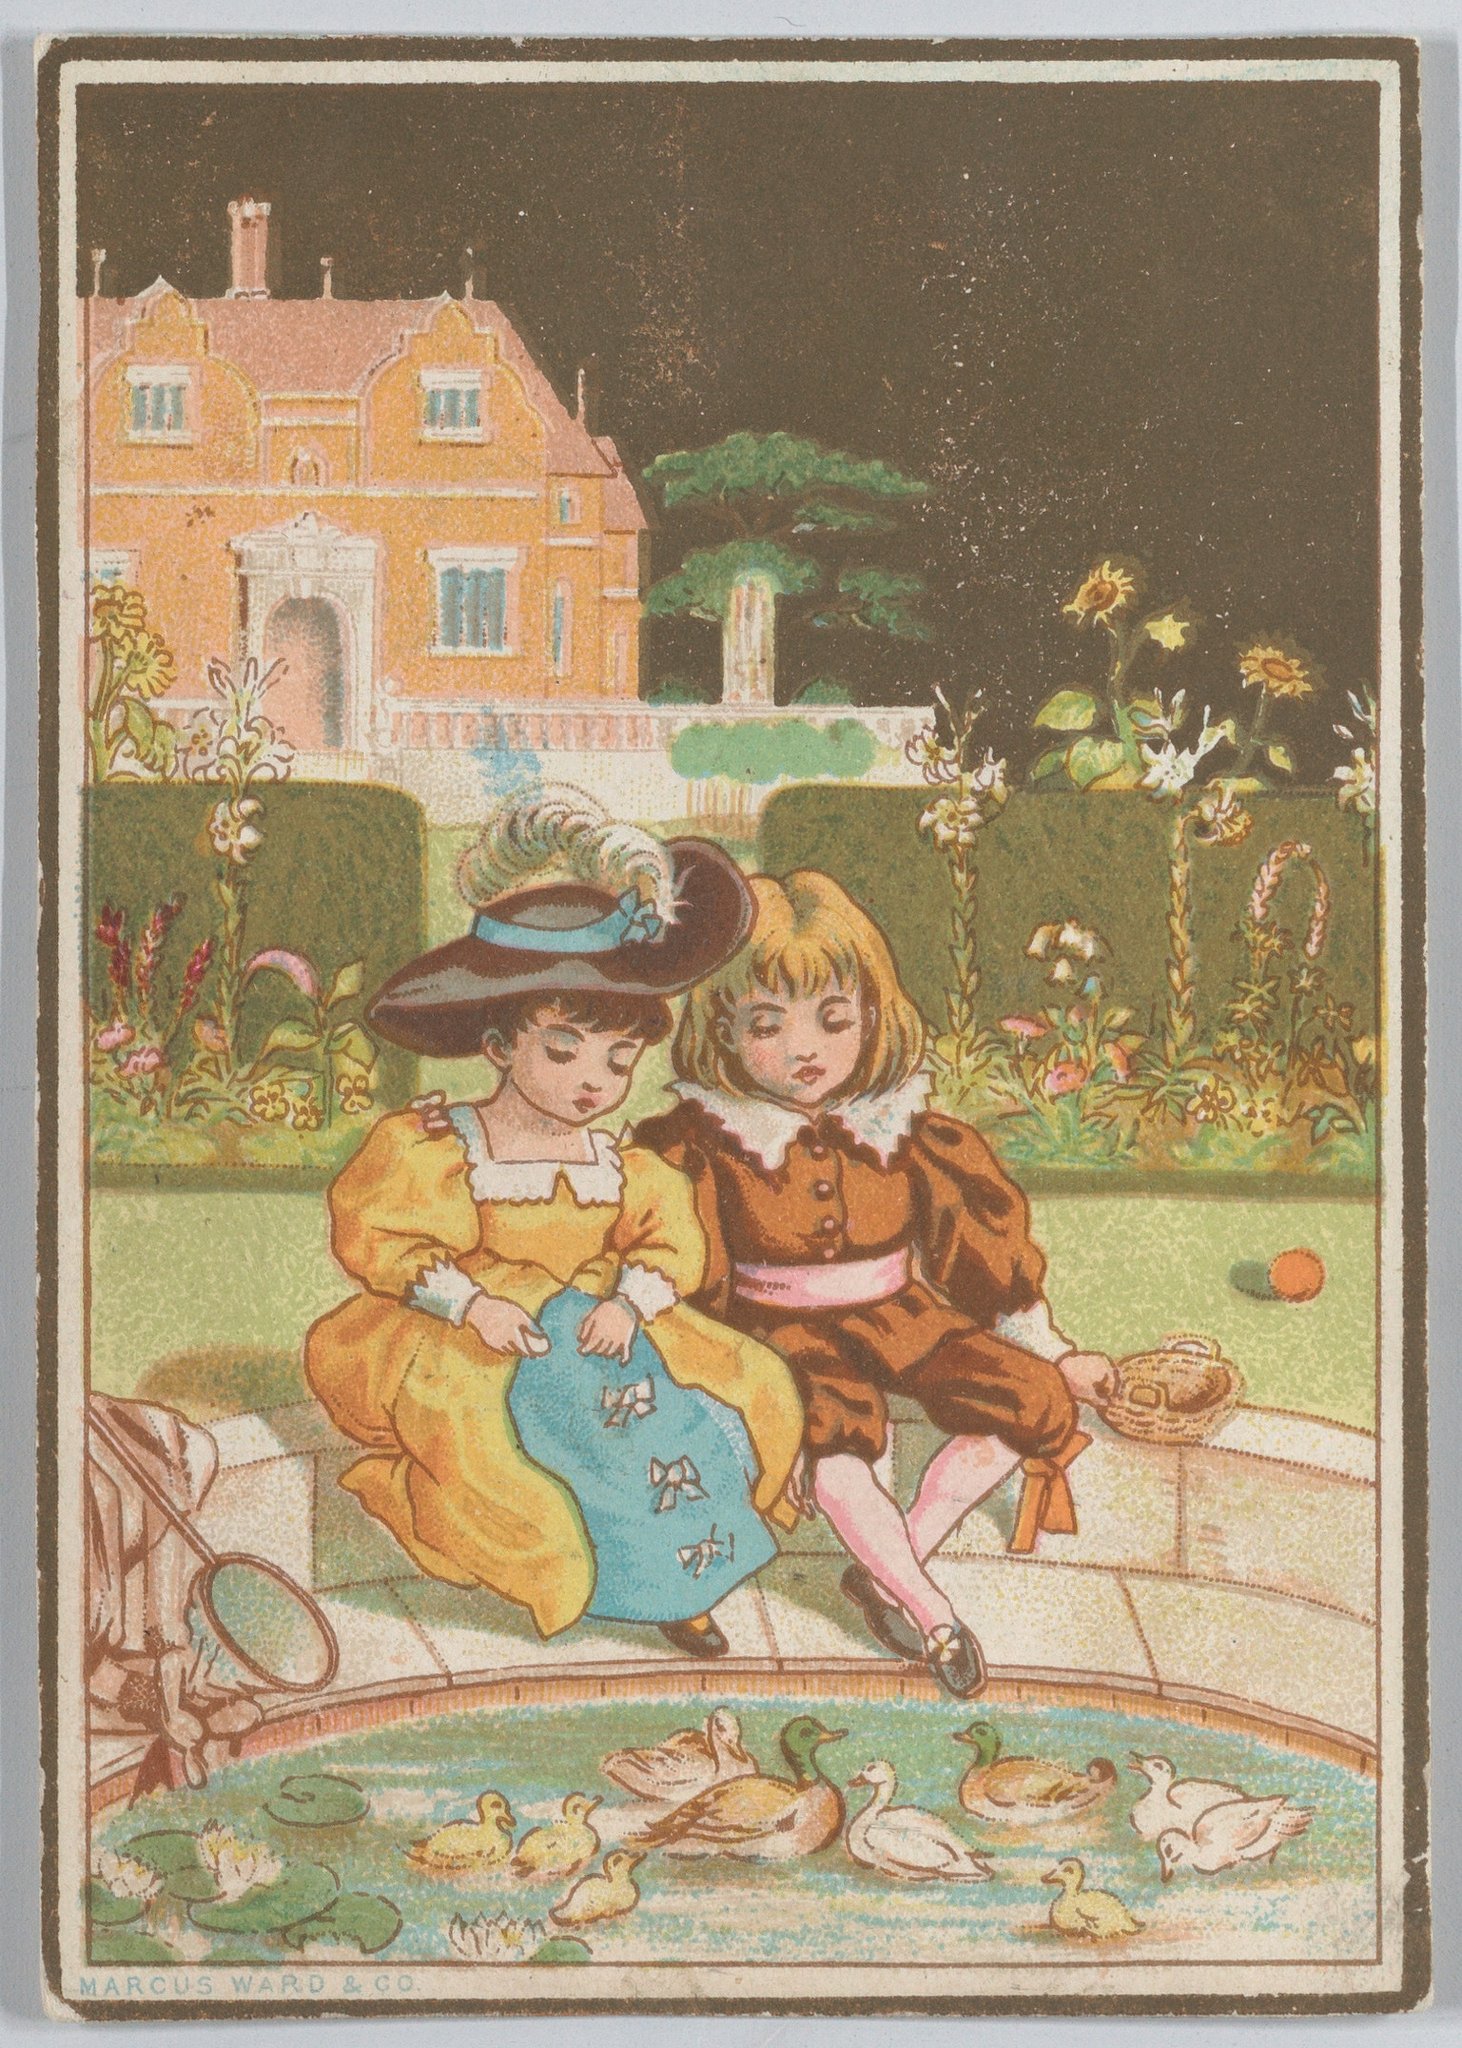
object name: valentine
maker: kate greenaway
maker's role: artist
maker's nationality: british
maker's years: 1846-1901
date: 1880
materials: gold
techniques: chromolithography, gilding, lithograph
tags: ducks,boys,girls